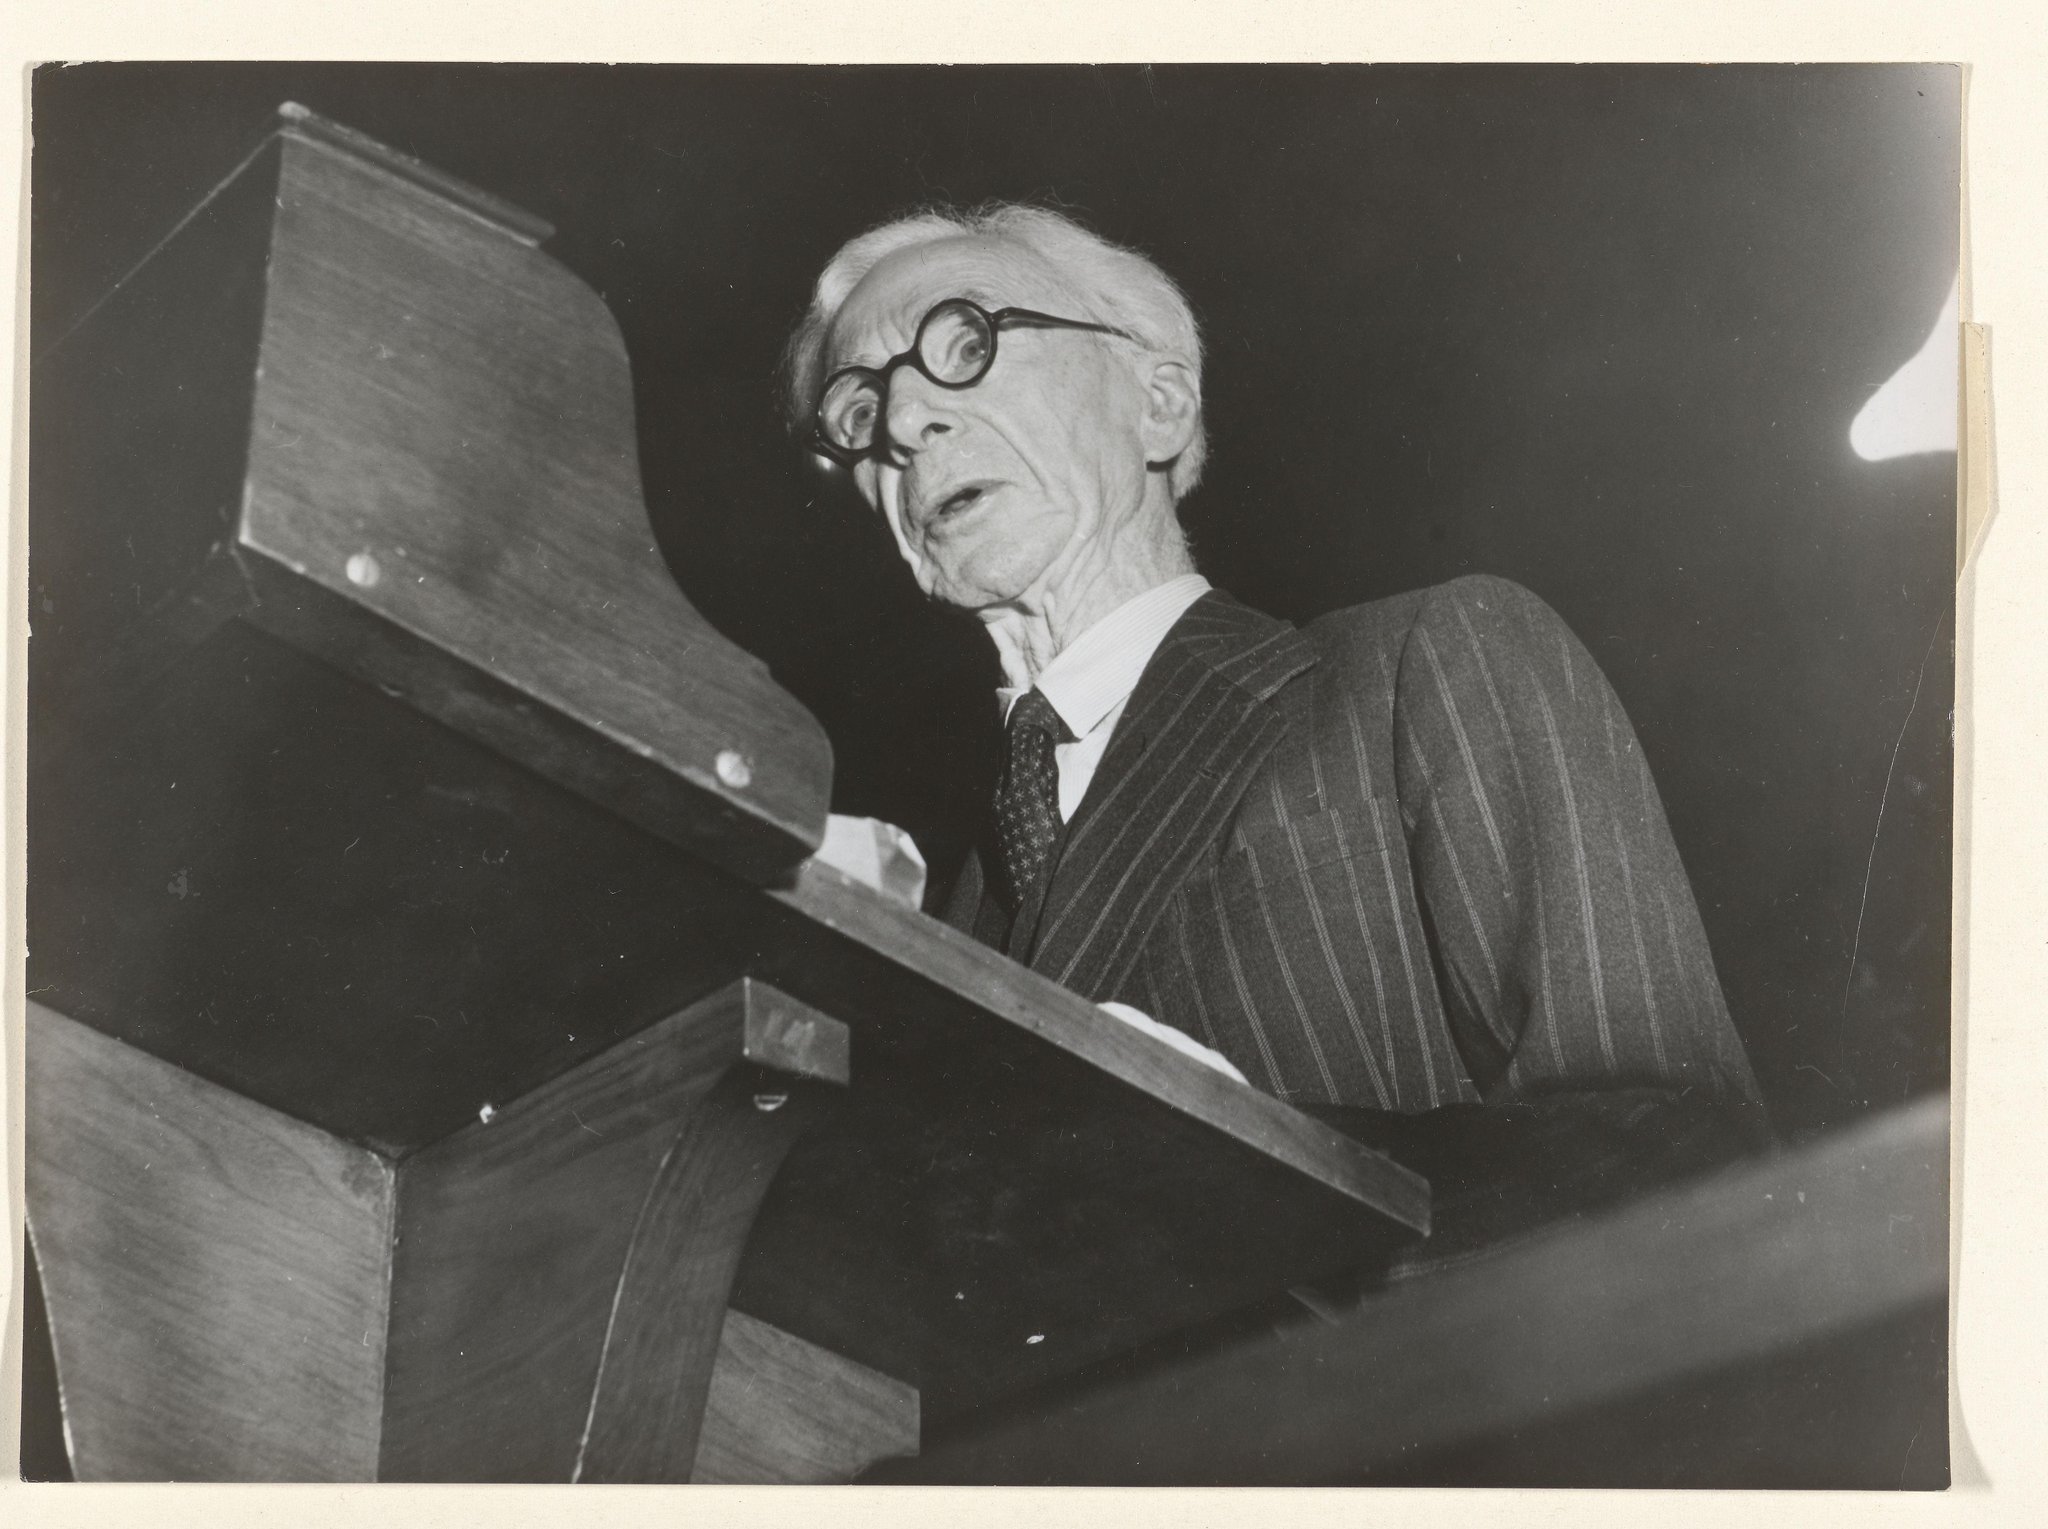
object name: photograph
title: Nobel prize winner speaks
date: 1950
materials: photographic support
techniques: gelatin silver print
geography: london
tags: new york (city)